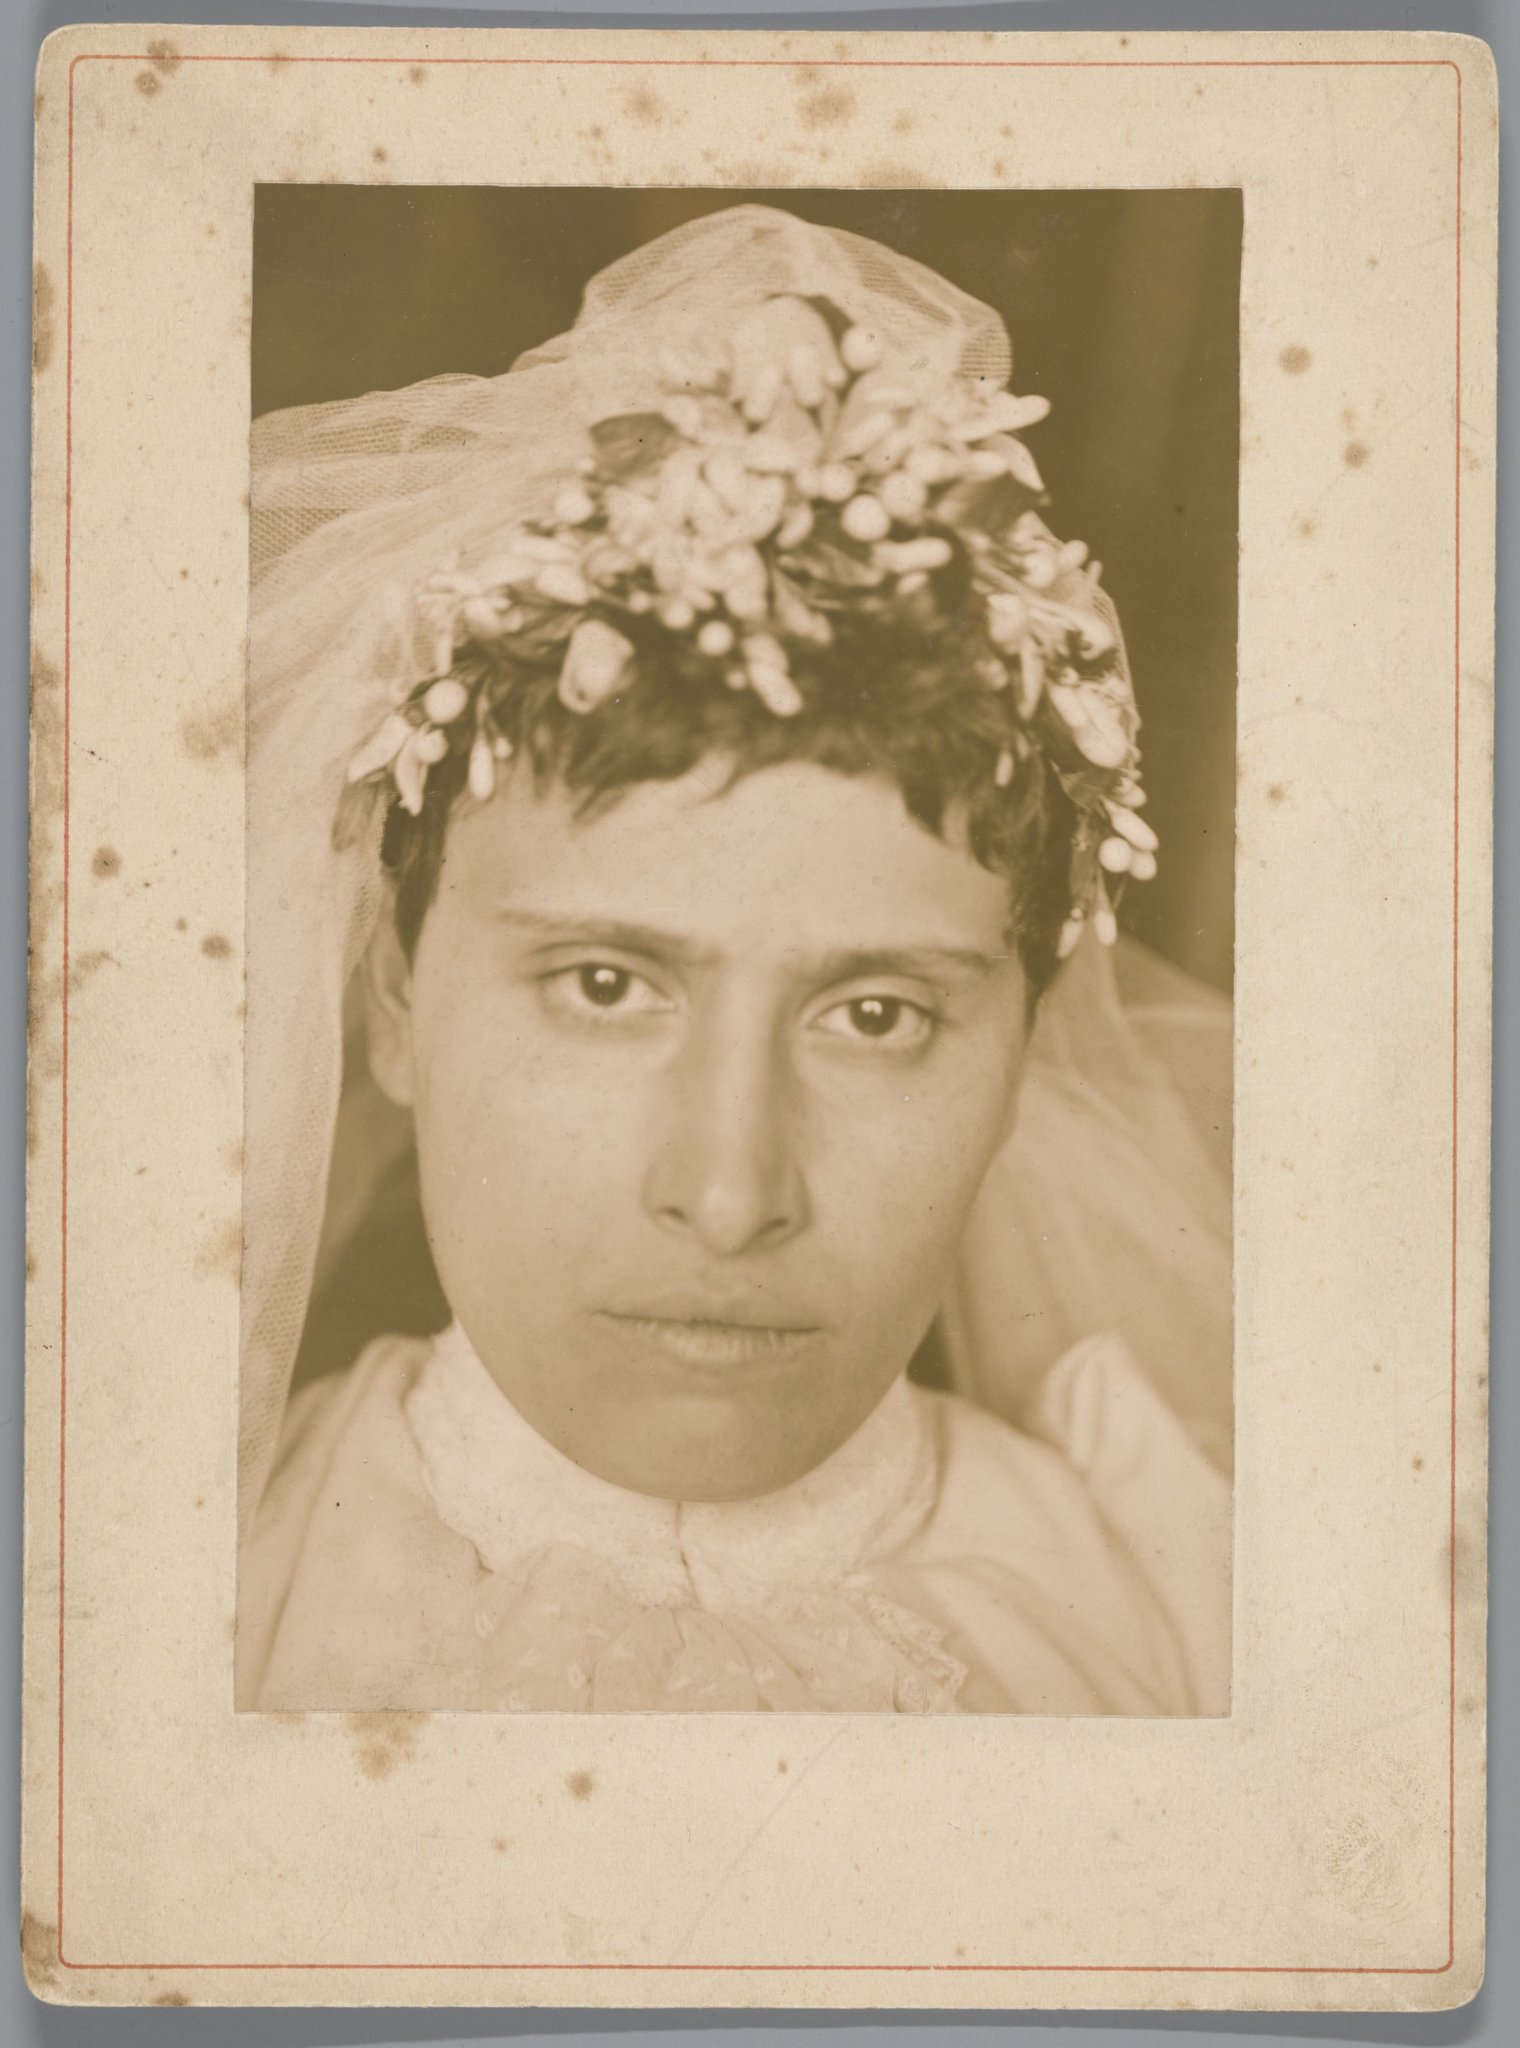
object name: photograph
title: Rachel Aletrino-Mendes da Costa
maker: willem witsen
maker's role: draughtsman, painter, print maker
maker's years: 1860-1923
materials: cardboard, paper, photographic support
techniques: gelatin silver print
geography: amsterdam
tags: rachel aletrino-mendes da costa